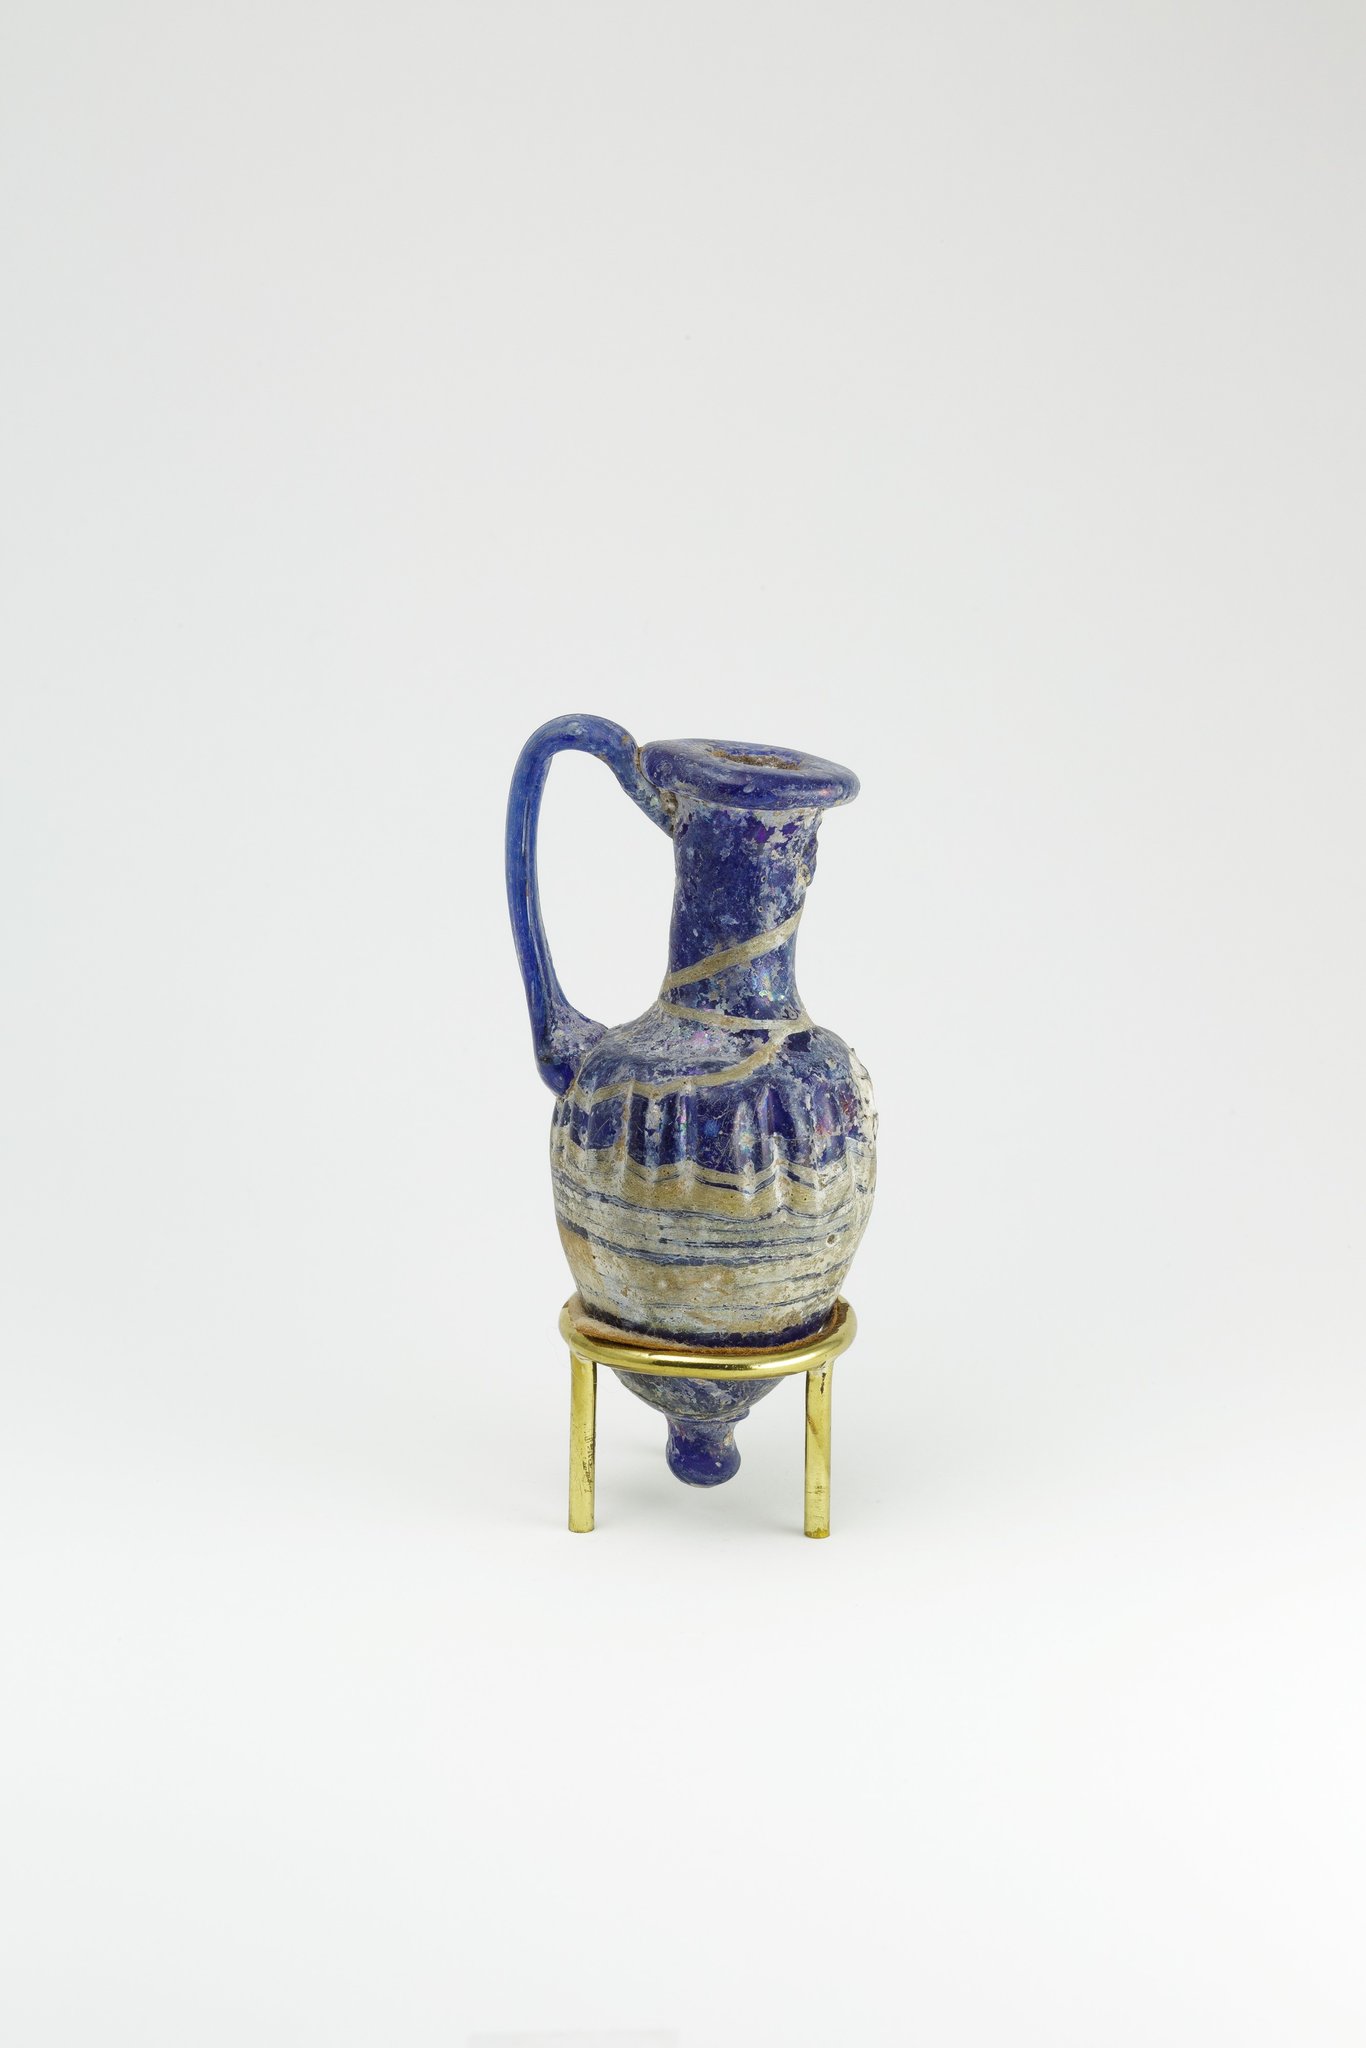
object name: vase, amphoriskos, polychrome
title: Perfume vase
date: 664-630 BCE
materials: glass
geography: egypt